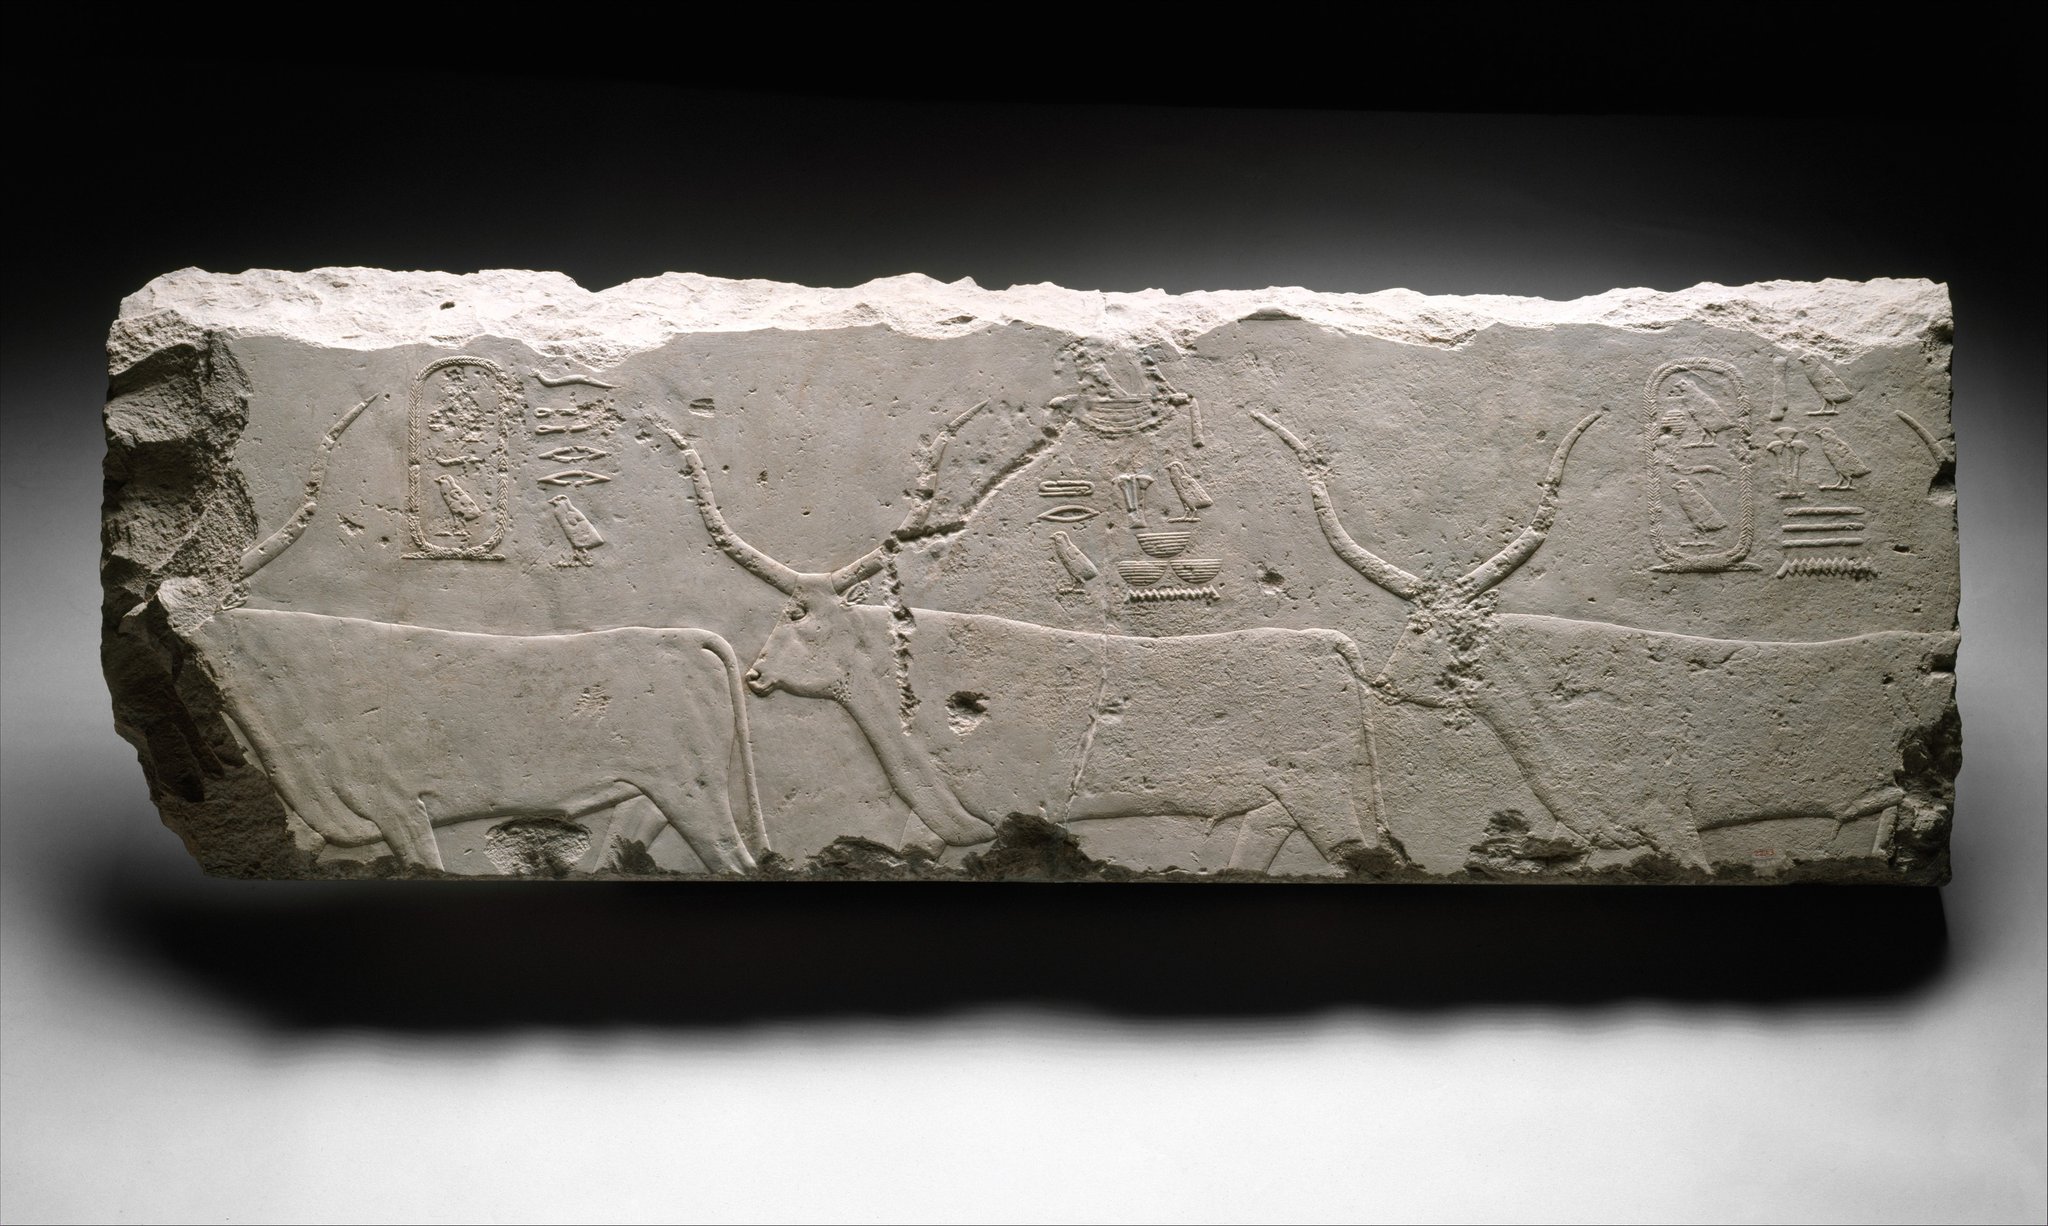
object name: relief, king khufu's cattle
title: Relief fragment with king Khufu's cattle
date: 2551-2528 BCE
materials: limestone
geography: egypt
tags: animals